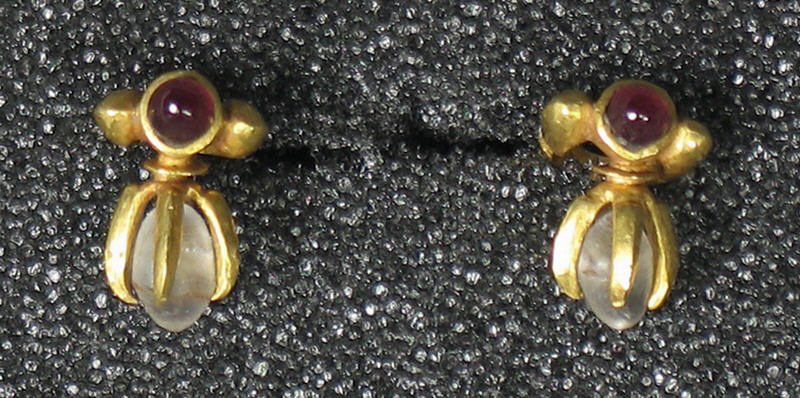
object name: pair of ear ornament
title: Pair of Ear ornaments, Ruby and Crystal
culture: indonesian, central java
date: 701-1200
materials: gold